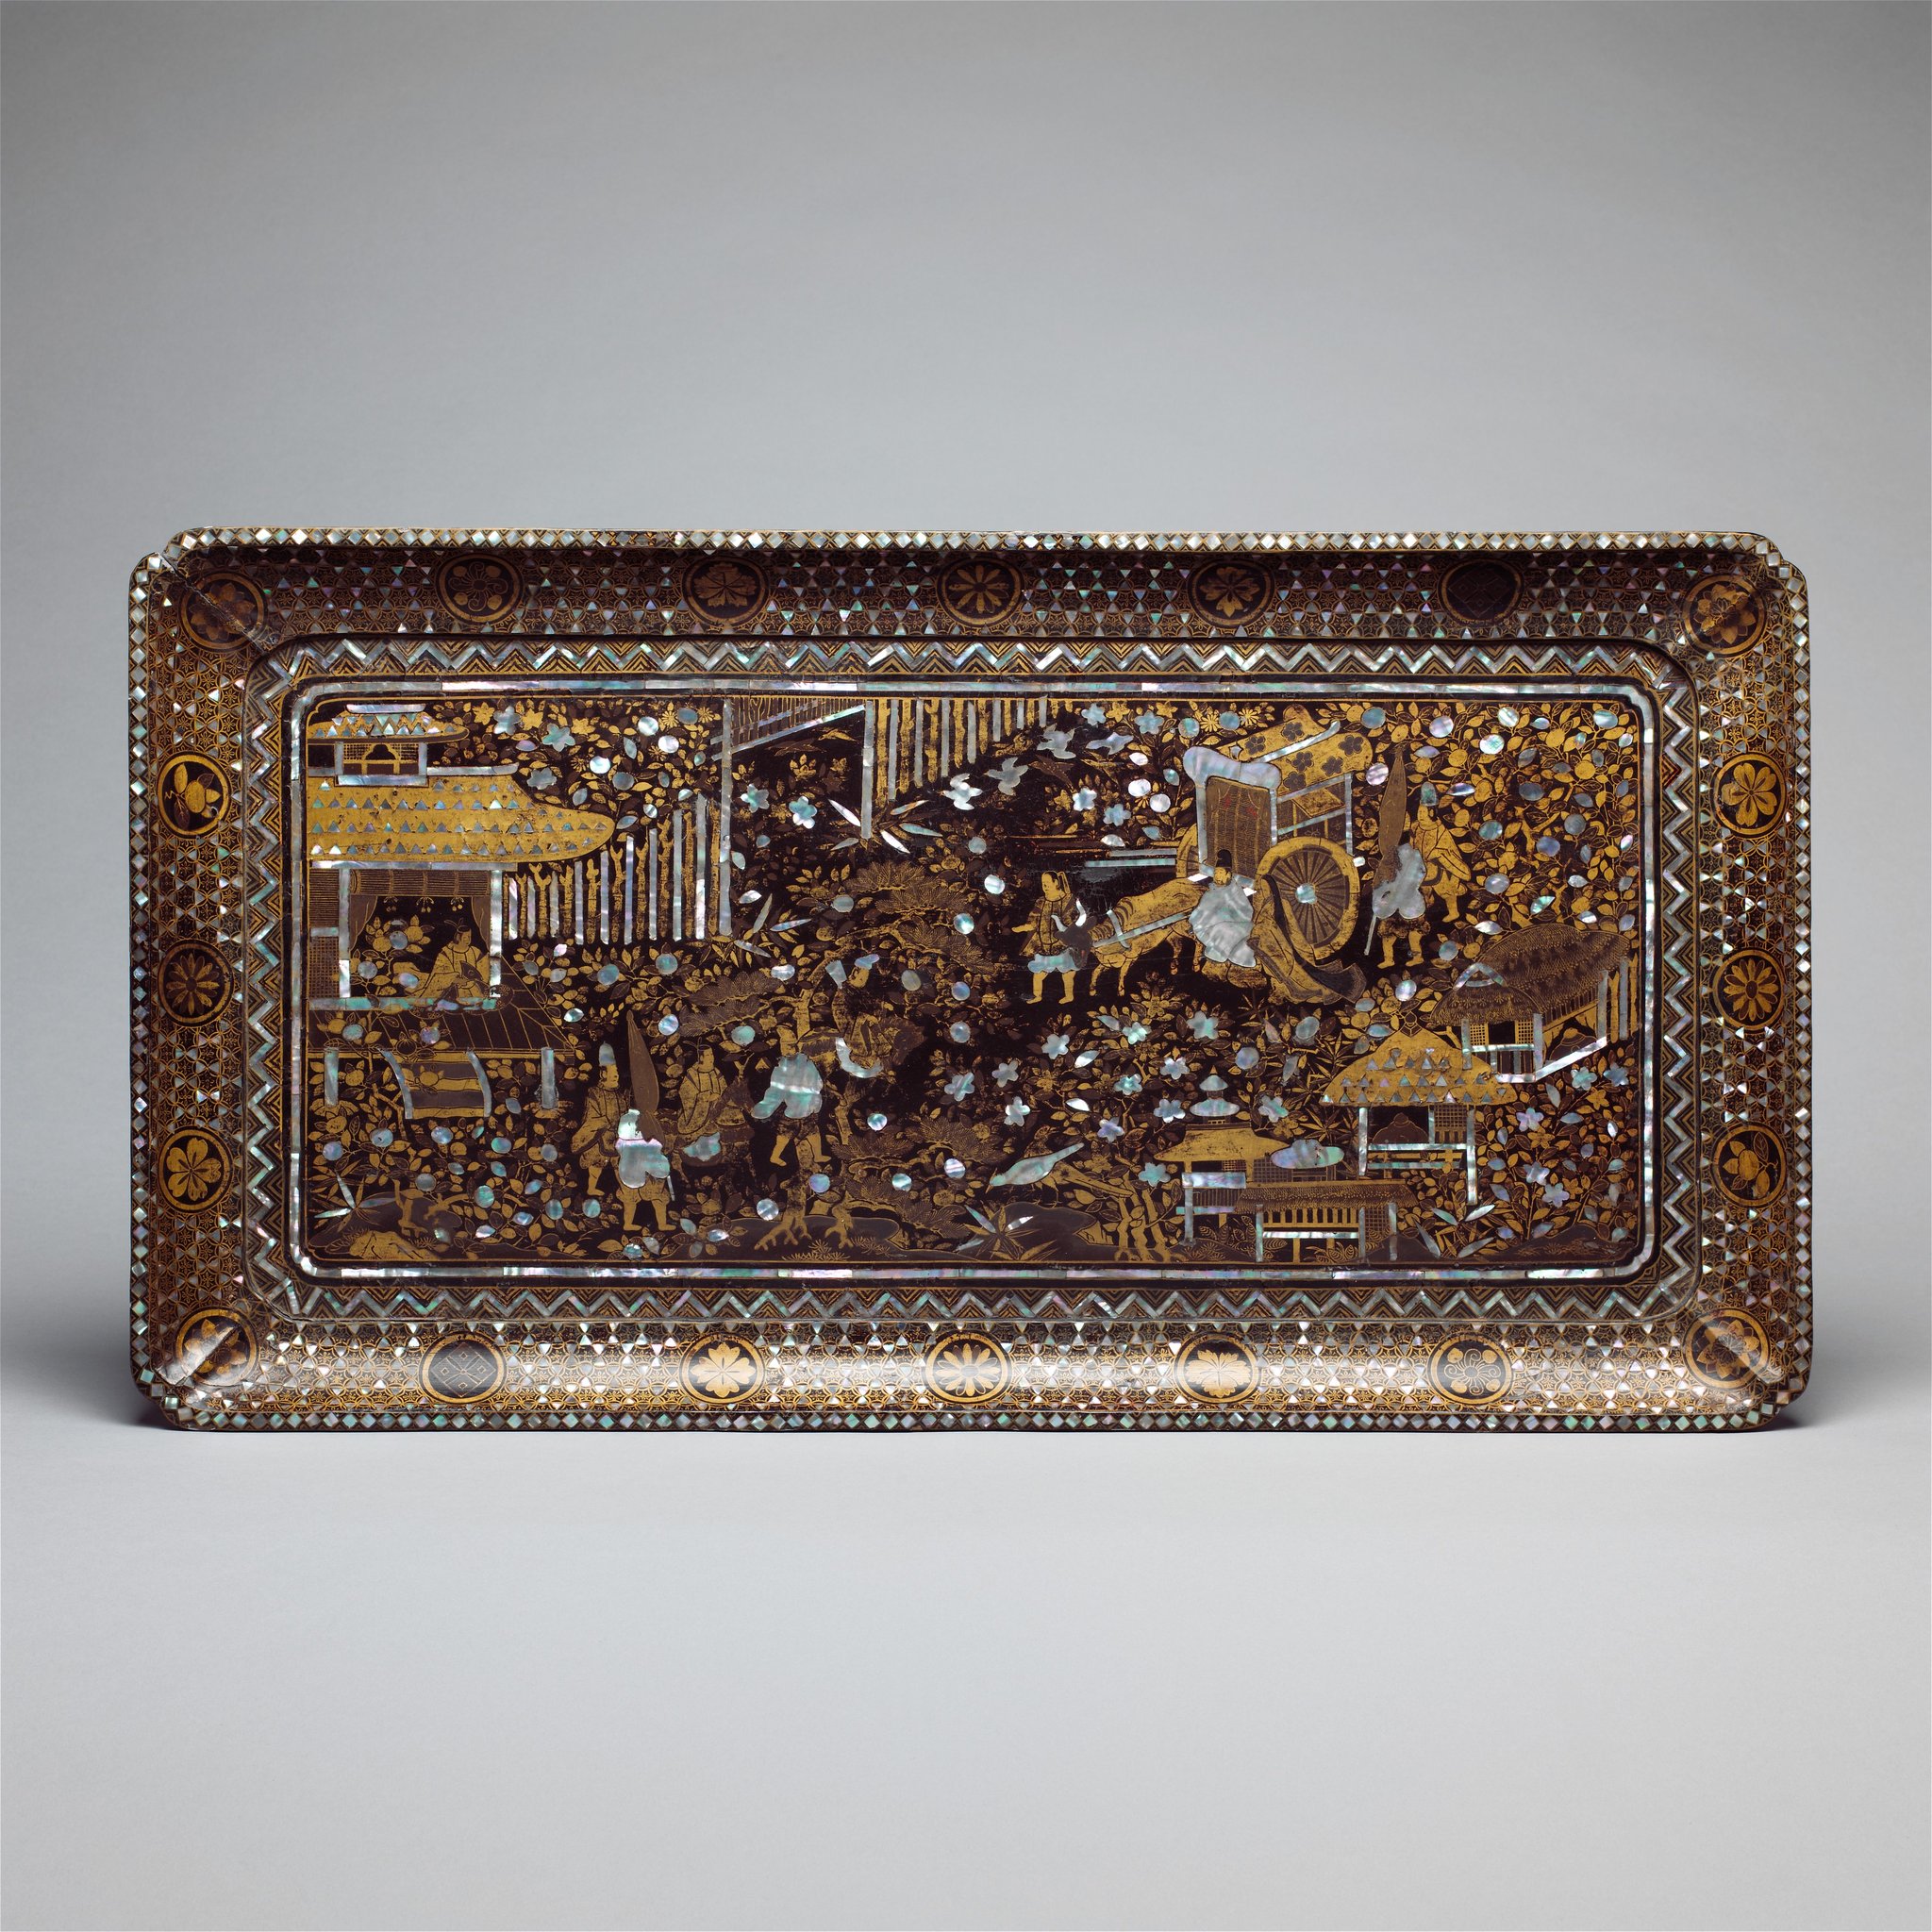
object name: tray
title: Tray with Scene from the Tale of Genji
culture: japanese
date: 1601-1633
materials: gold, lacquer, mother of pearl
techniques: inlay, maki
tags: human figures